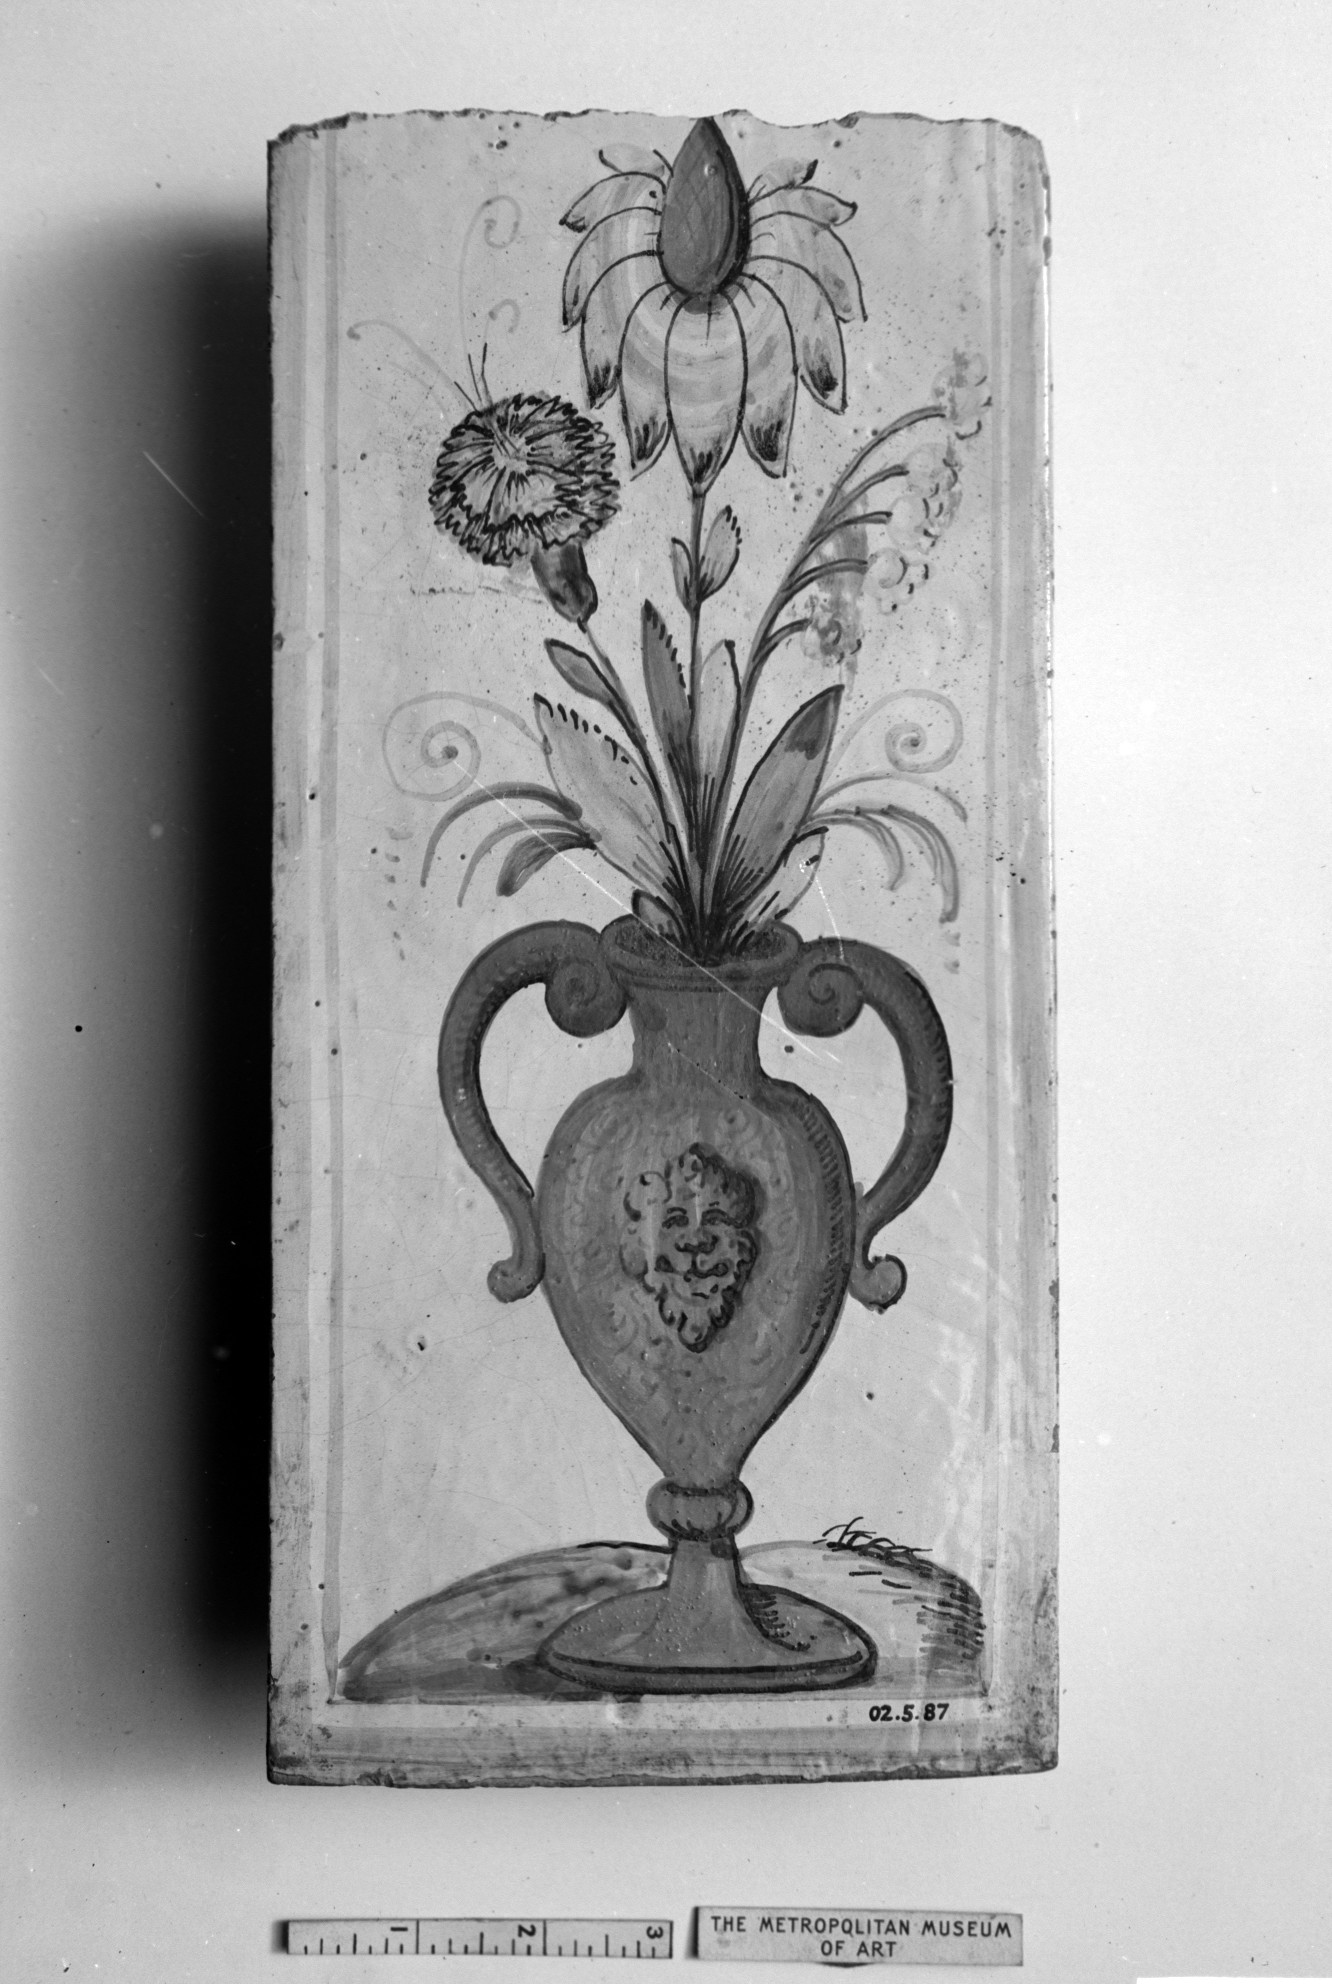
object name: tile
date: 1660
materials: earthenware